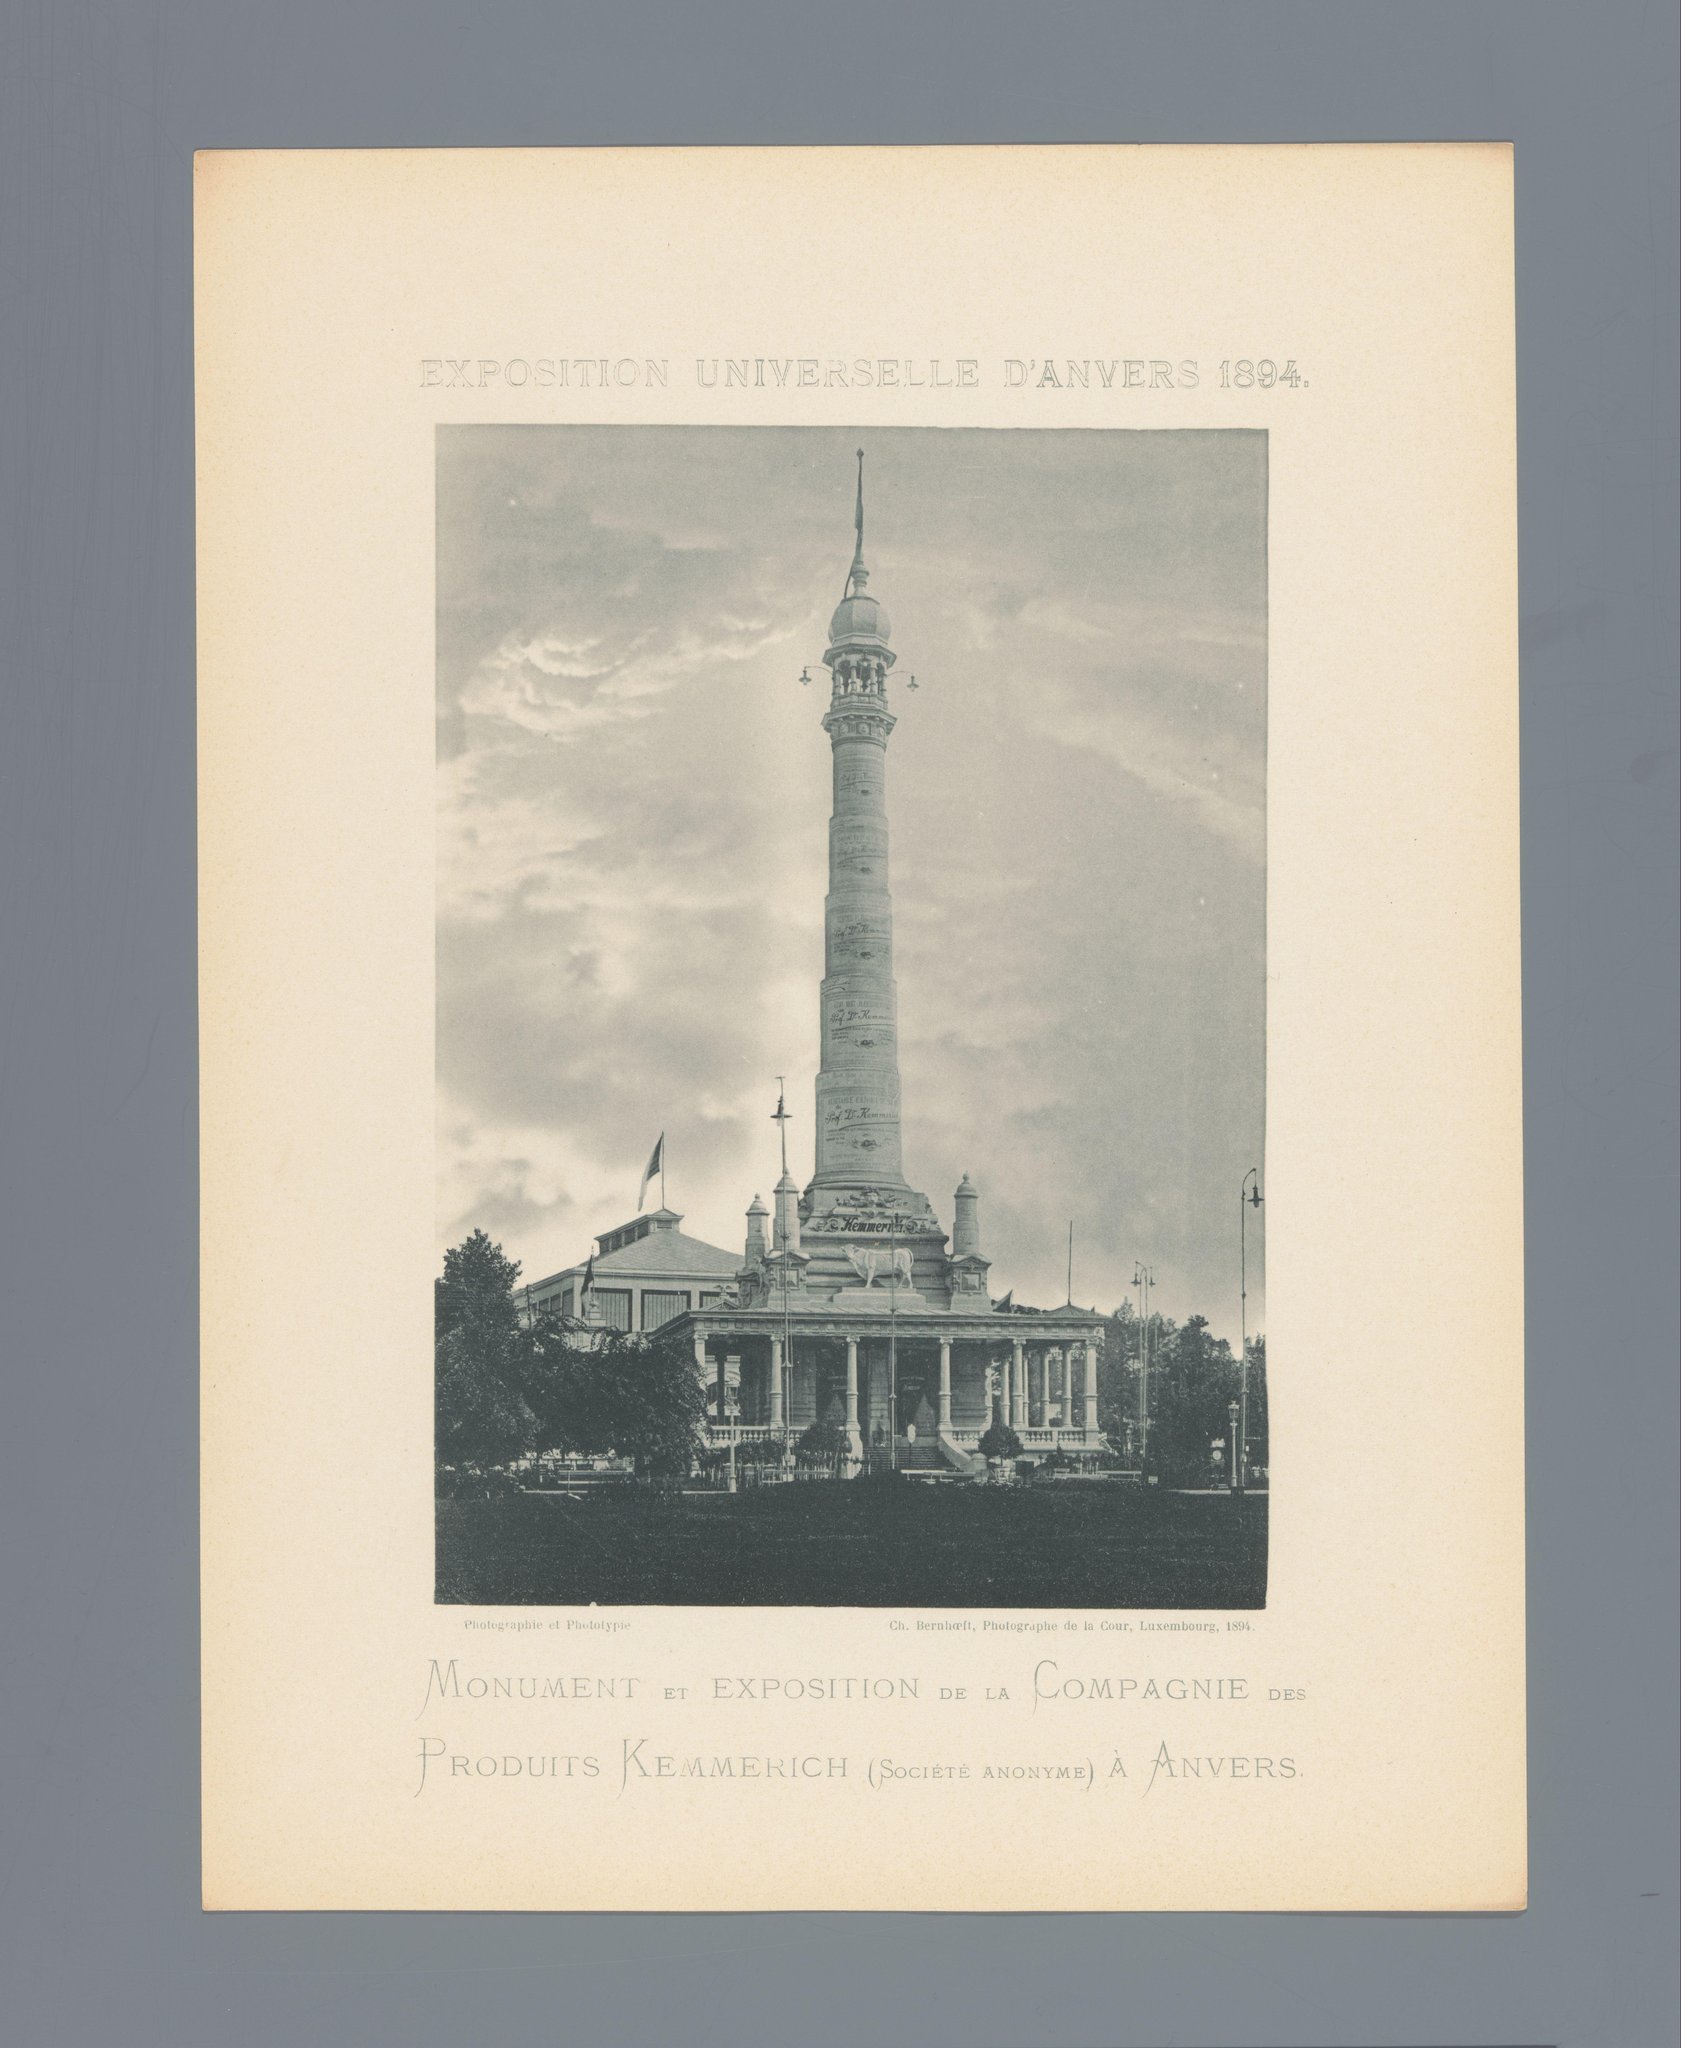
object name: photomechanical print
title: Monument van Kammerich tijdens de Wereldtentoonstelling van 1894 te Antwerpen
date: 1894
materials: paper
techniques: photograph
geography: antwerp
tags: world fair, world exhibition, monument, statue, antwerp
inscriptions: inscription: ‘Exposition Universelle D'Anvers 1894’